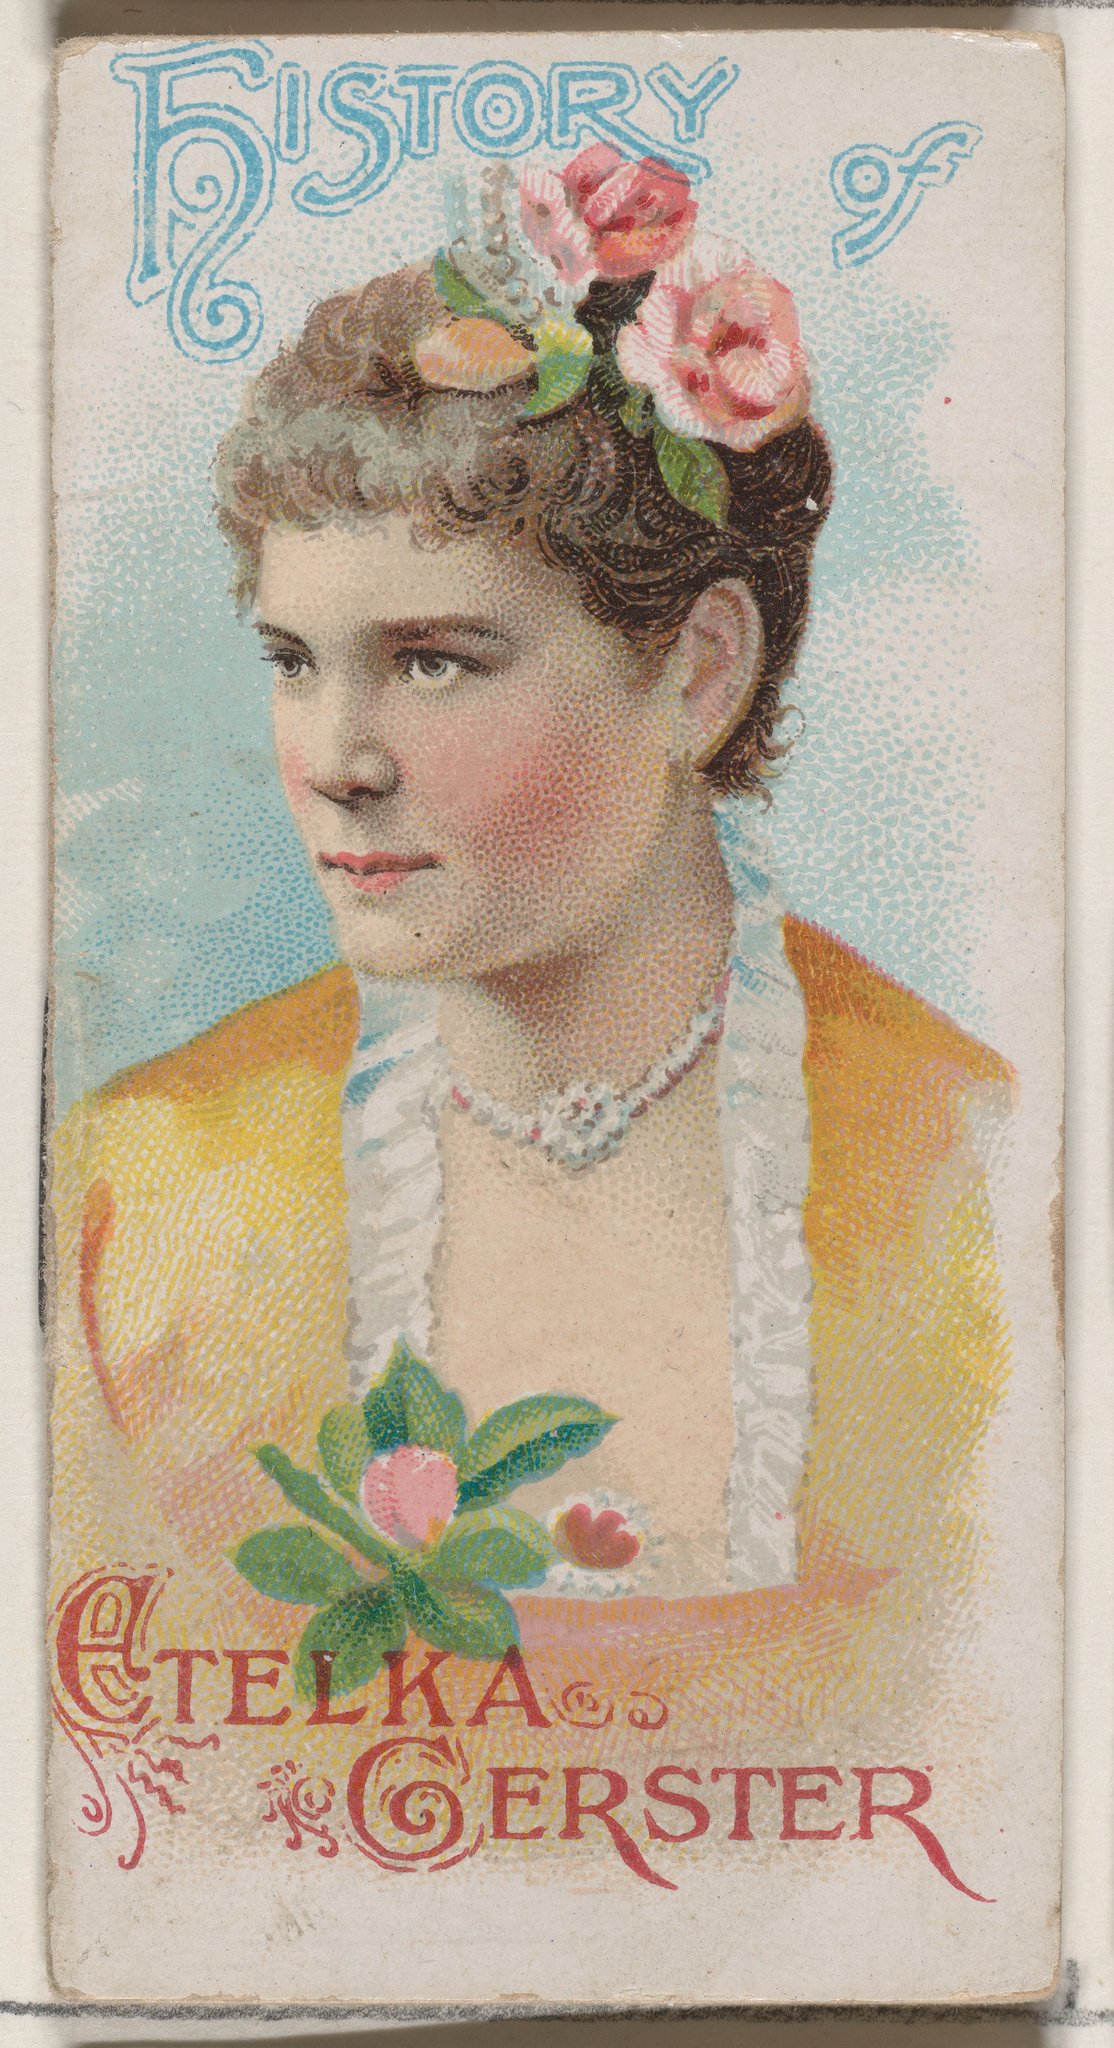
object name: print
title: History of Etelka Gerster, from the Histories of Poor Boys and Famous People series of booklets (N79) for Duke brand cigarettes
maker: w. duke, sons & co.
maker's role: publisher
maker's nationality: american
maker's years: 1870-1920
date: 1888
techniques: color lithograph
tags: women